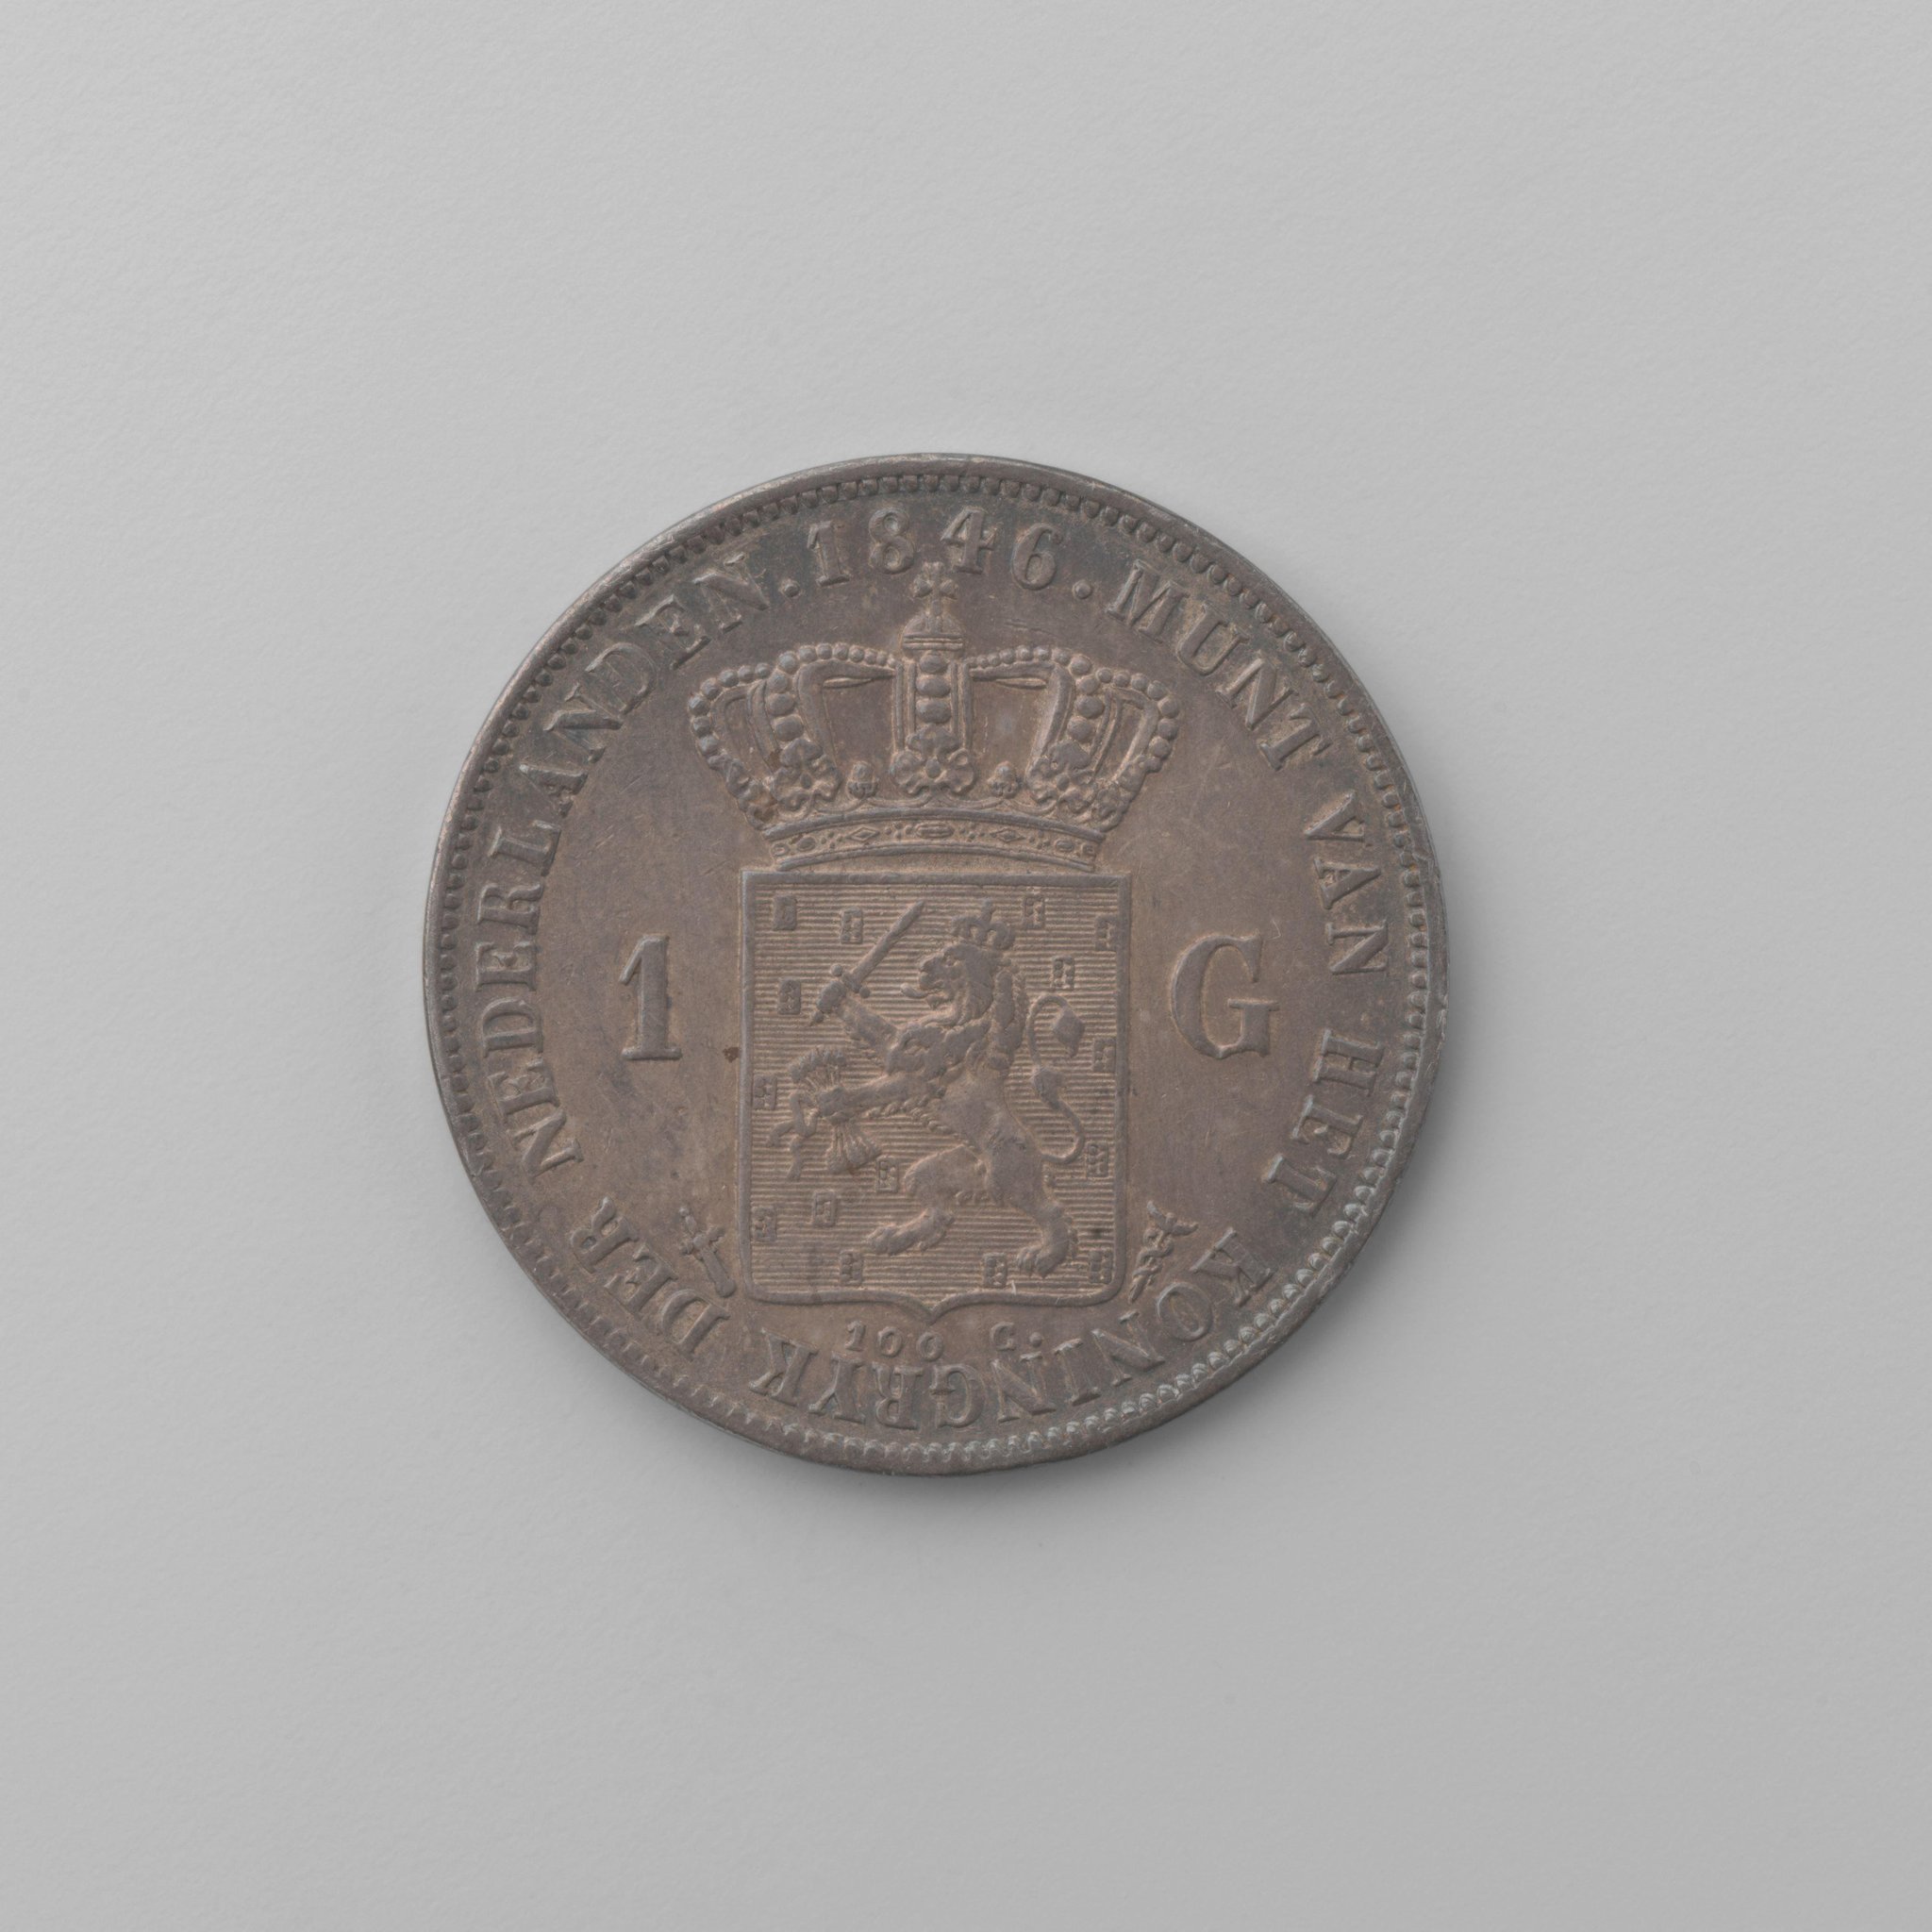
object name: coin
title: Nederland, gulden, 1846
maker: william ii of the netherlands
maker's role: koning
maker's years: 1792-1849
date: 1846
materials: silver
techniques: striking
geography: utrecht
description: Zilveren munt. Voorzijde: borstbeeld naar links. Keerzijde: tussen waarde-aanduiding 1 G gekroond rijkswapenschild. Jaartal boven kroon. Linksonder wapenschild muntmeesterteken: zwaard. Randschrift.